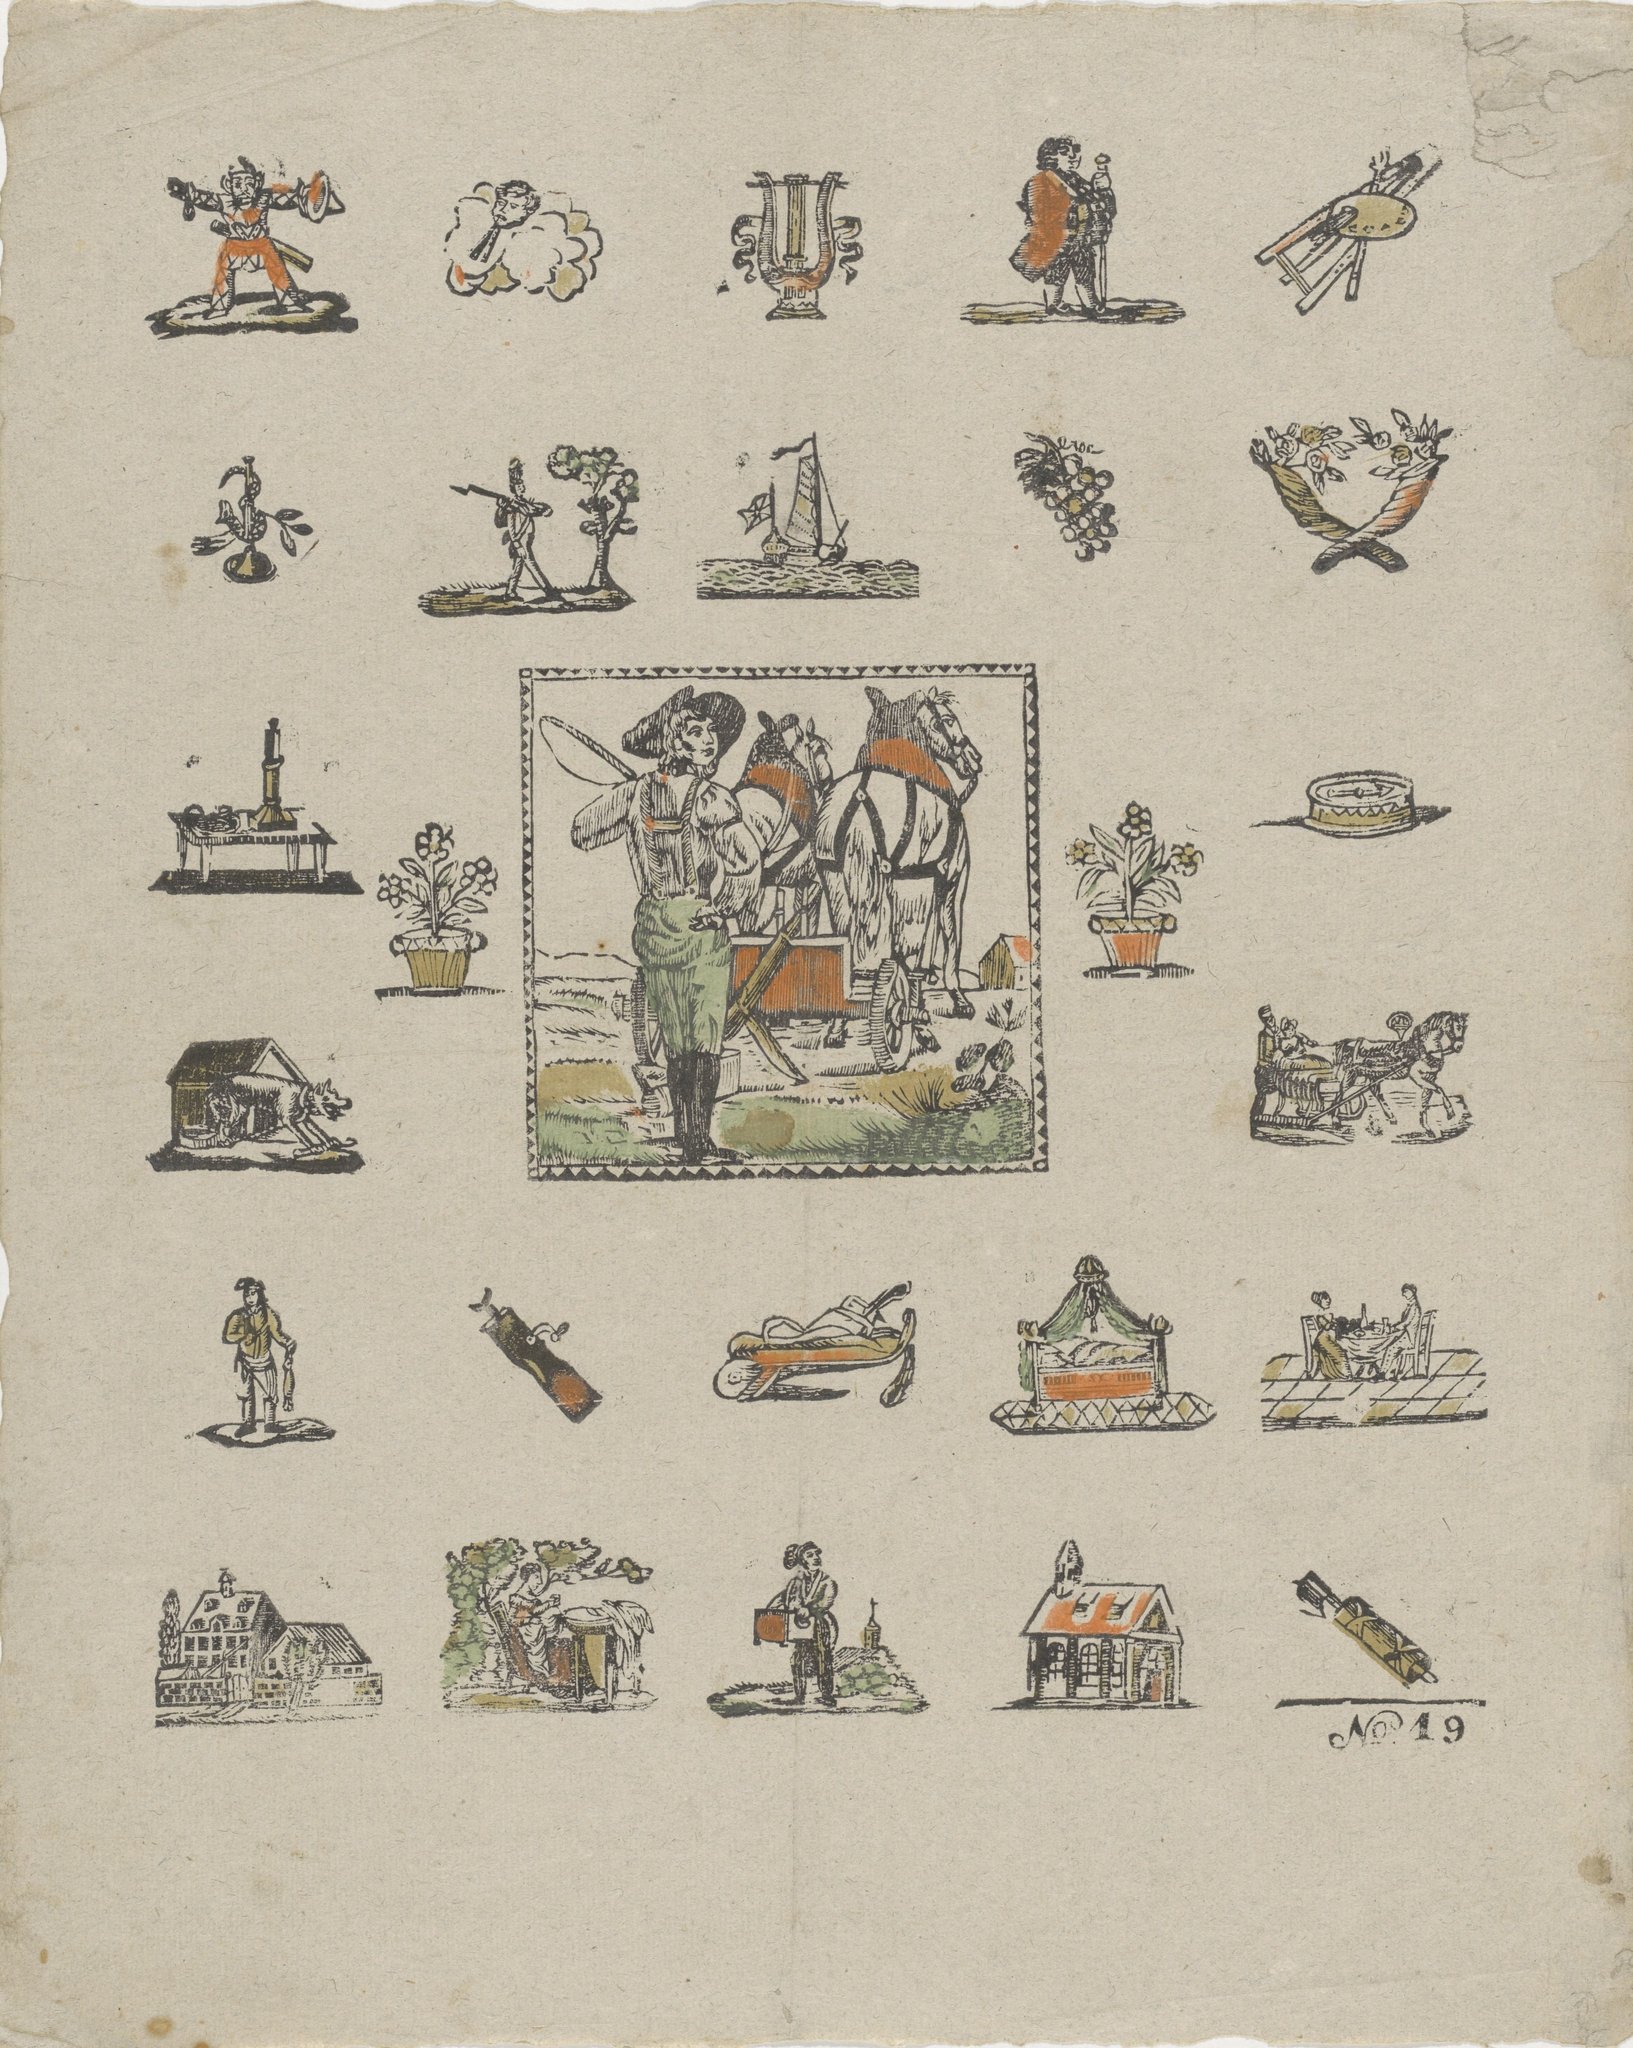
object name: print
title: Man met een ploeg en twee paarden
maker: Anonymous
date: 1700-1899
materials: paper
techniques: colour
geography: netherlands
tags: human types, farmers, characters (human types), ploughing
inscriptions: collector's mark: Lugt 2228, collector's mark: Lugt 2760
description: Blad met een grote voorstelling van een man met een ploeg en twee paarden met daaromheen 26 kleine voorstellingen van figuren, voorwerpen en gebouwen. Genummerd rechtsonder: No. 19.